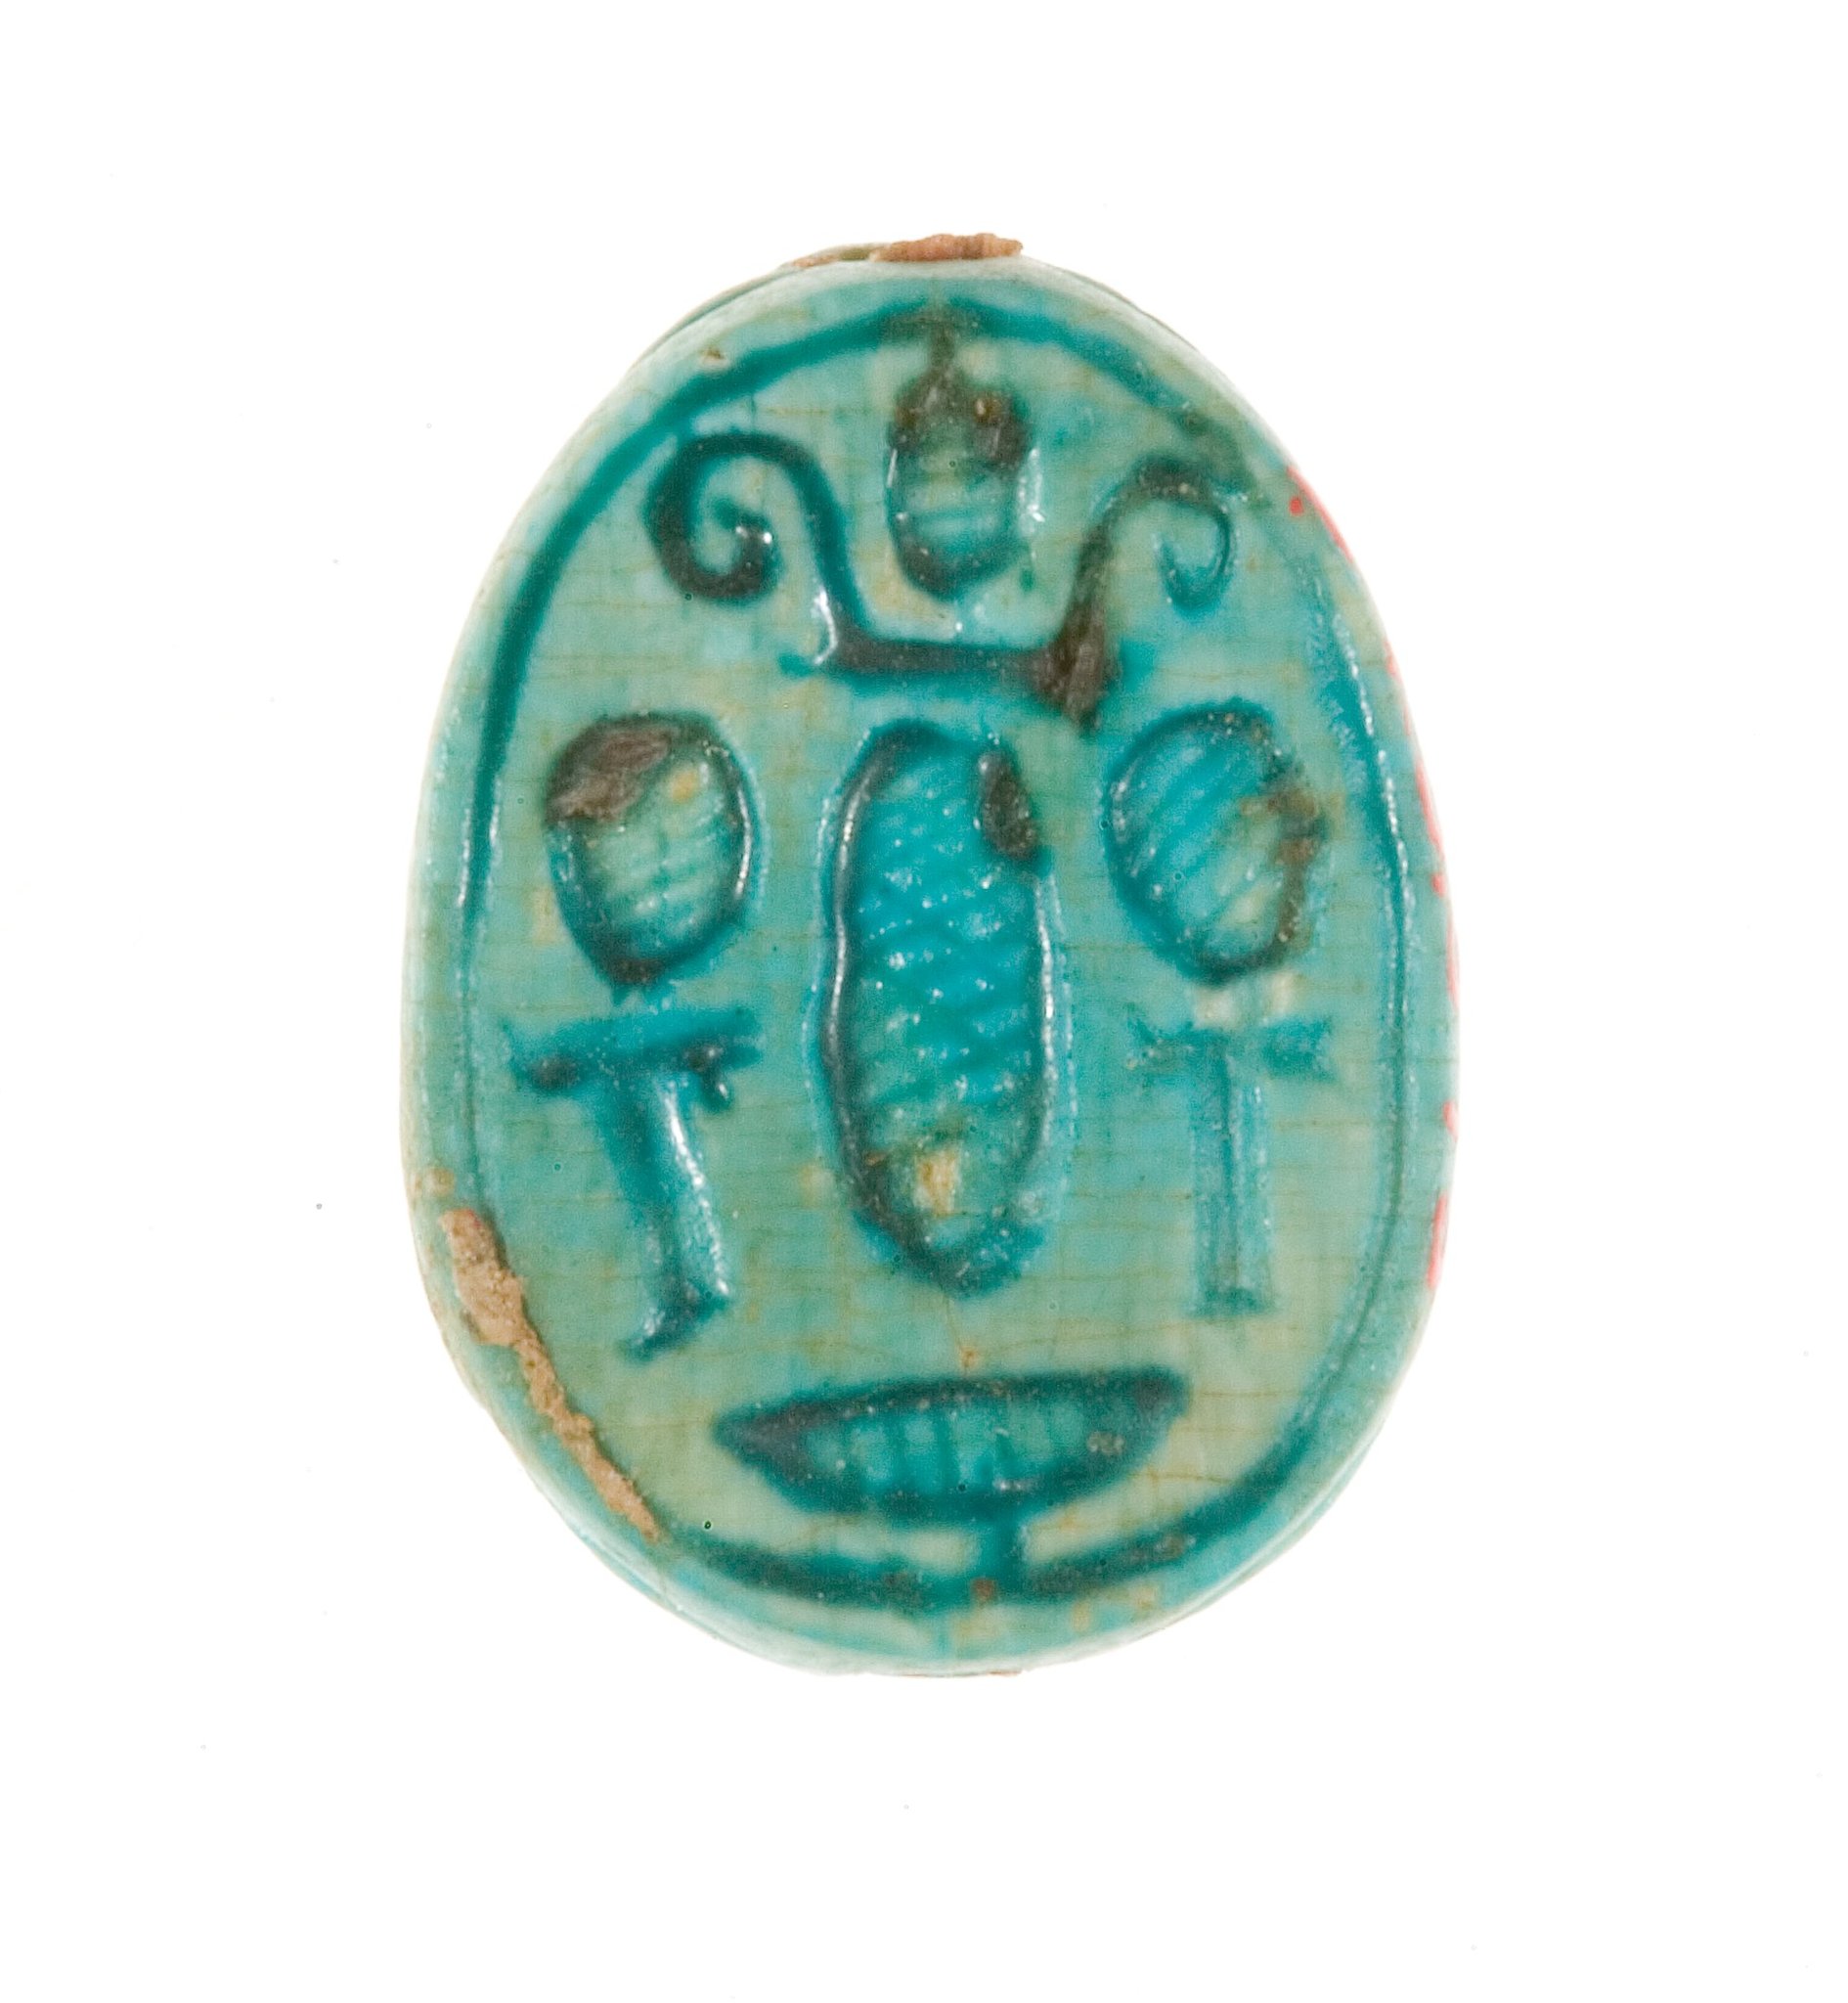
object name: scarab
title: Scarab Inscribed with a Hieroglyphic Motif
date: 1479-1458 BCE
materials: stone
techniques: glazing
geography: egypt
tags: hieroglyphs,scarabs